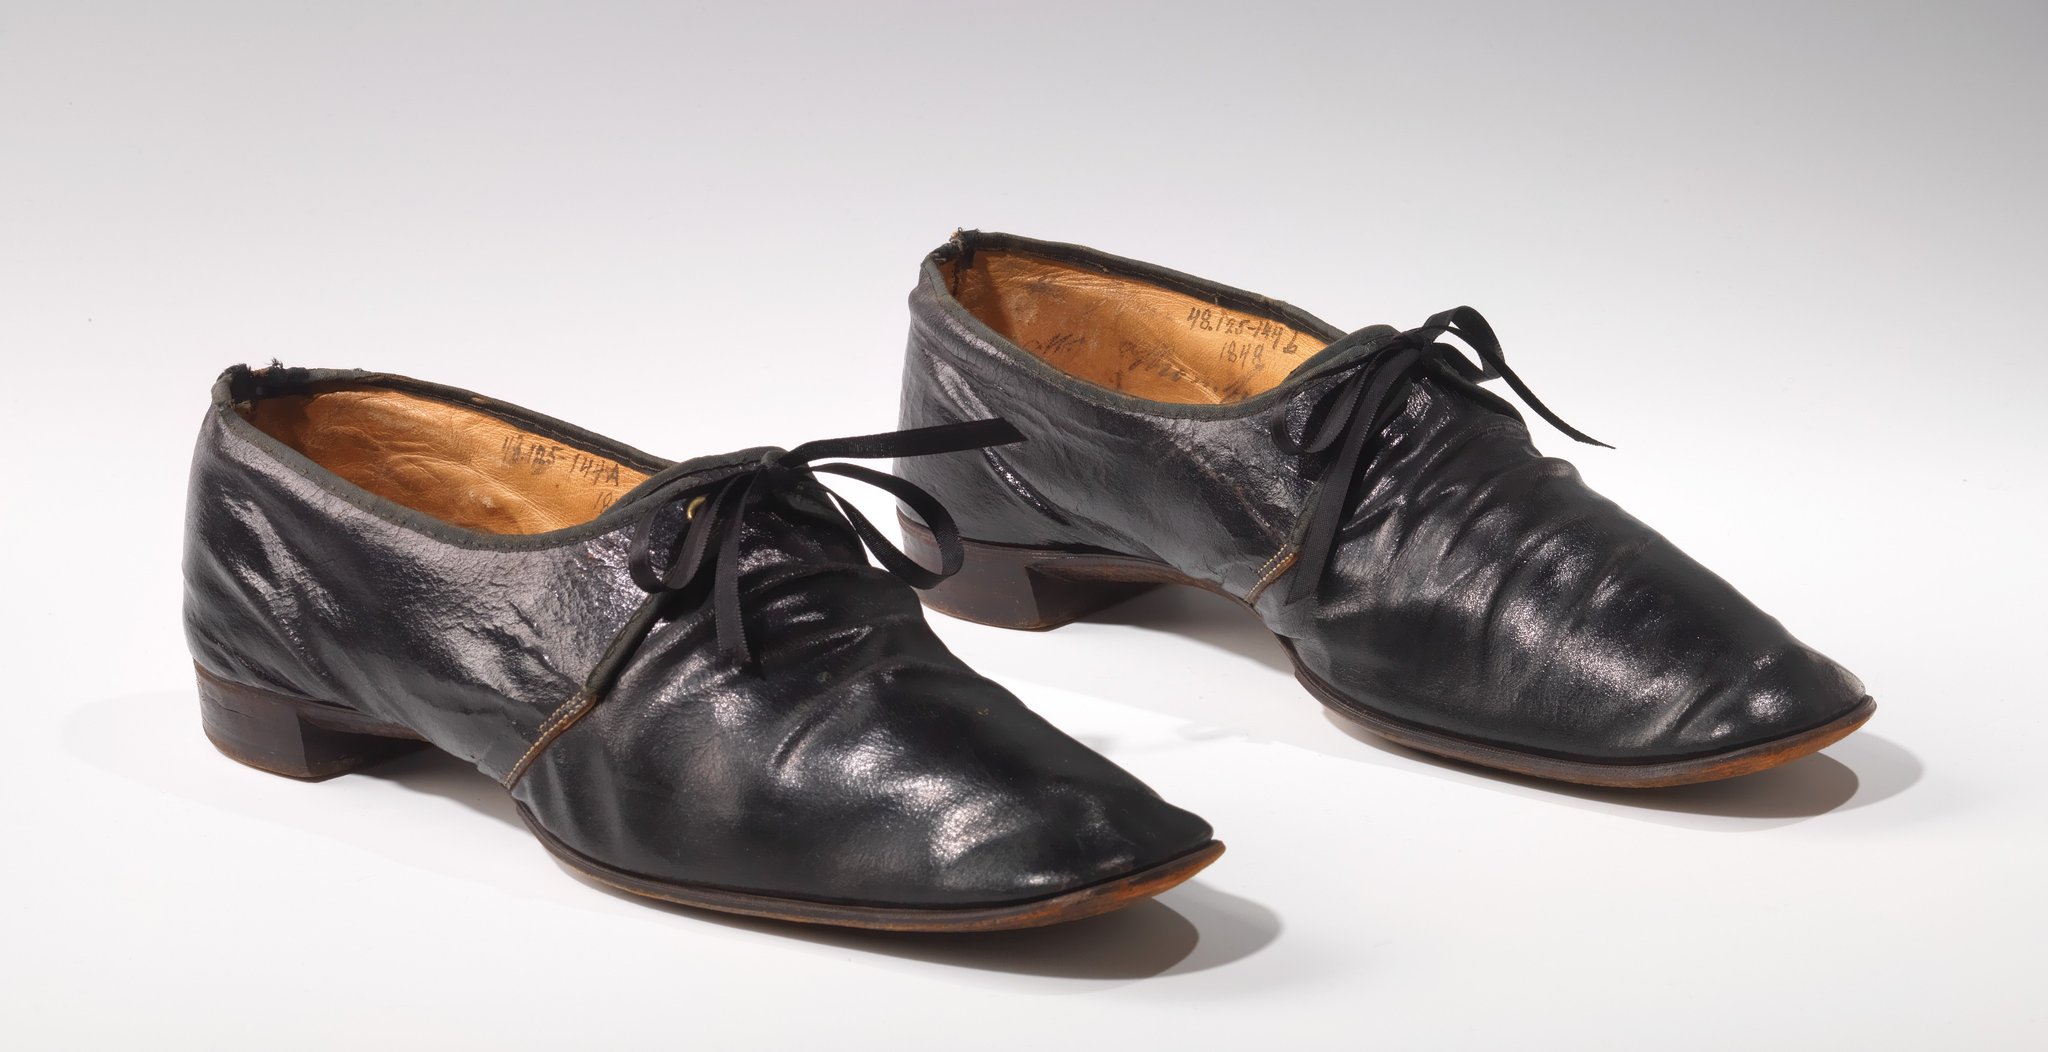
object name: shoe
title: Shoes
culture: american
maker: john golden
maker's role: designer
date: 1848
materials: leather